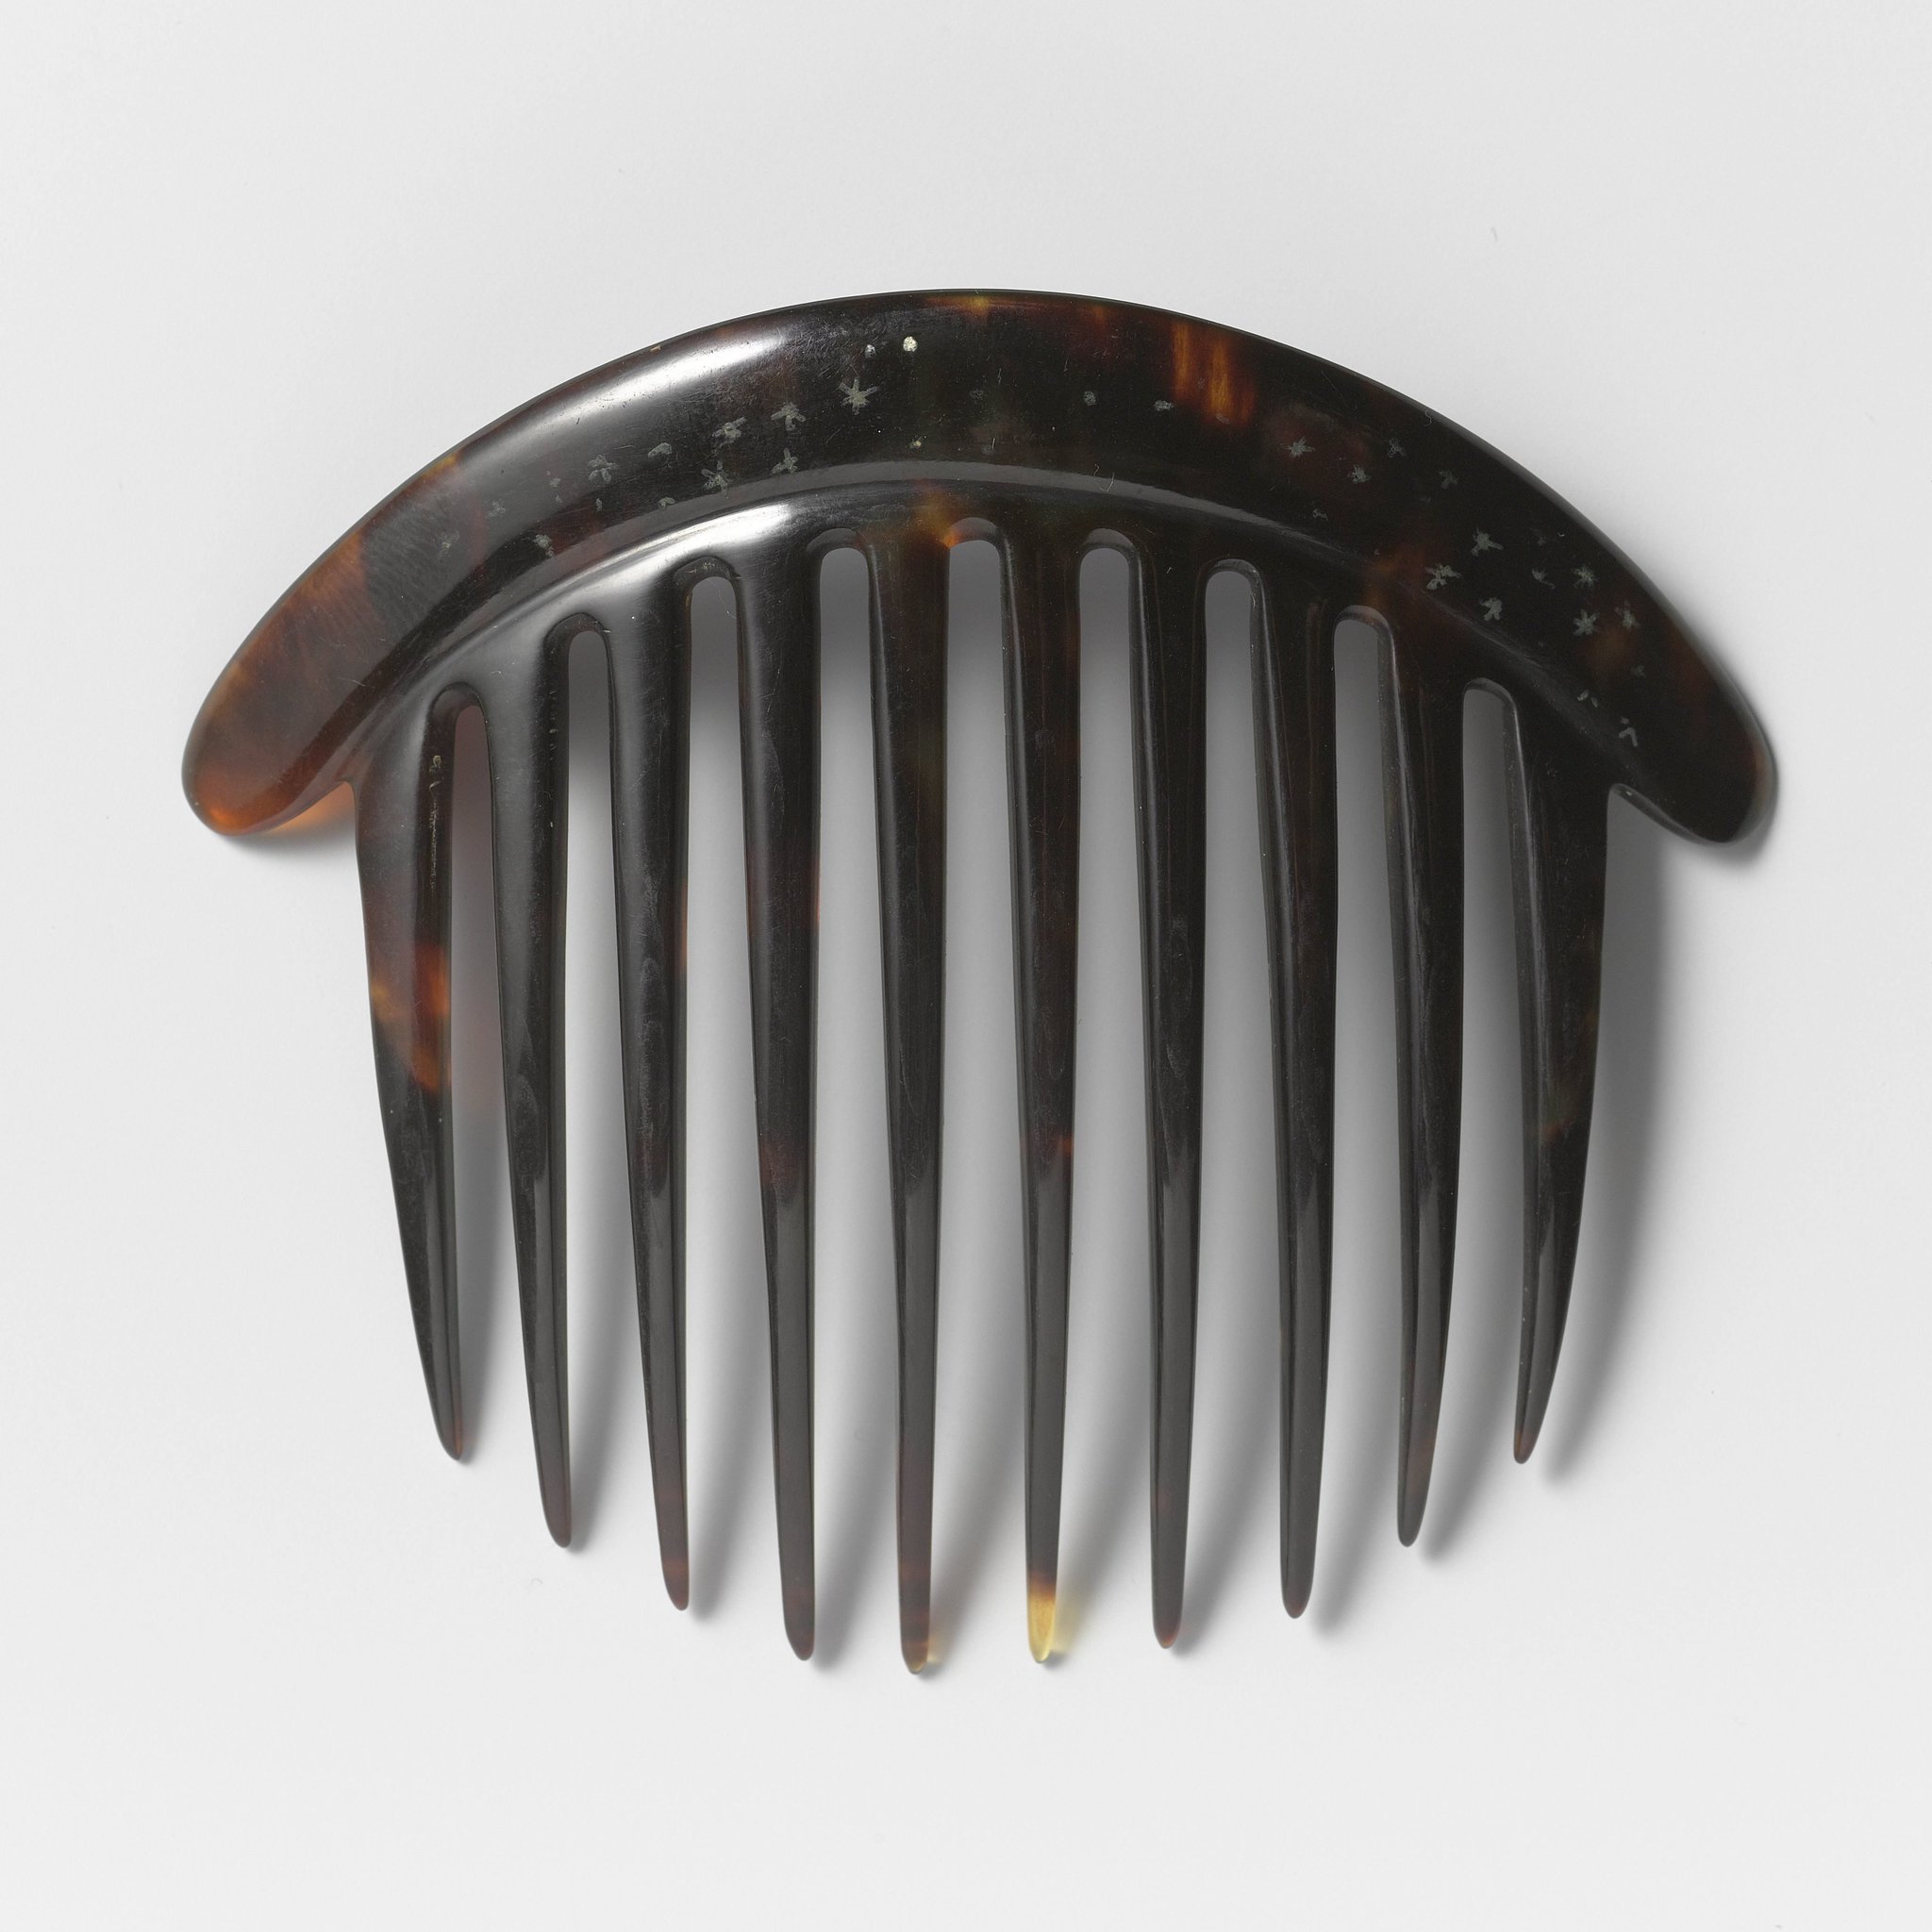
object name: comb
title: Haarkam van imitatie schildpad en hoorn met een smalle, onversierde ronde rug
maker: Anonymous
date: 1800-1900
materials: celluloid, horn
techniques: filing, polish, pressing, sawing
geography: netherlands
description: Haarkam van imitatie schildpad en hoorn met een smalle, onversierde ronde rug, die aan beide kanten van de tanden een stukje uitsteekt. Tien tanden.